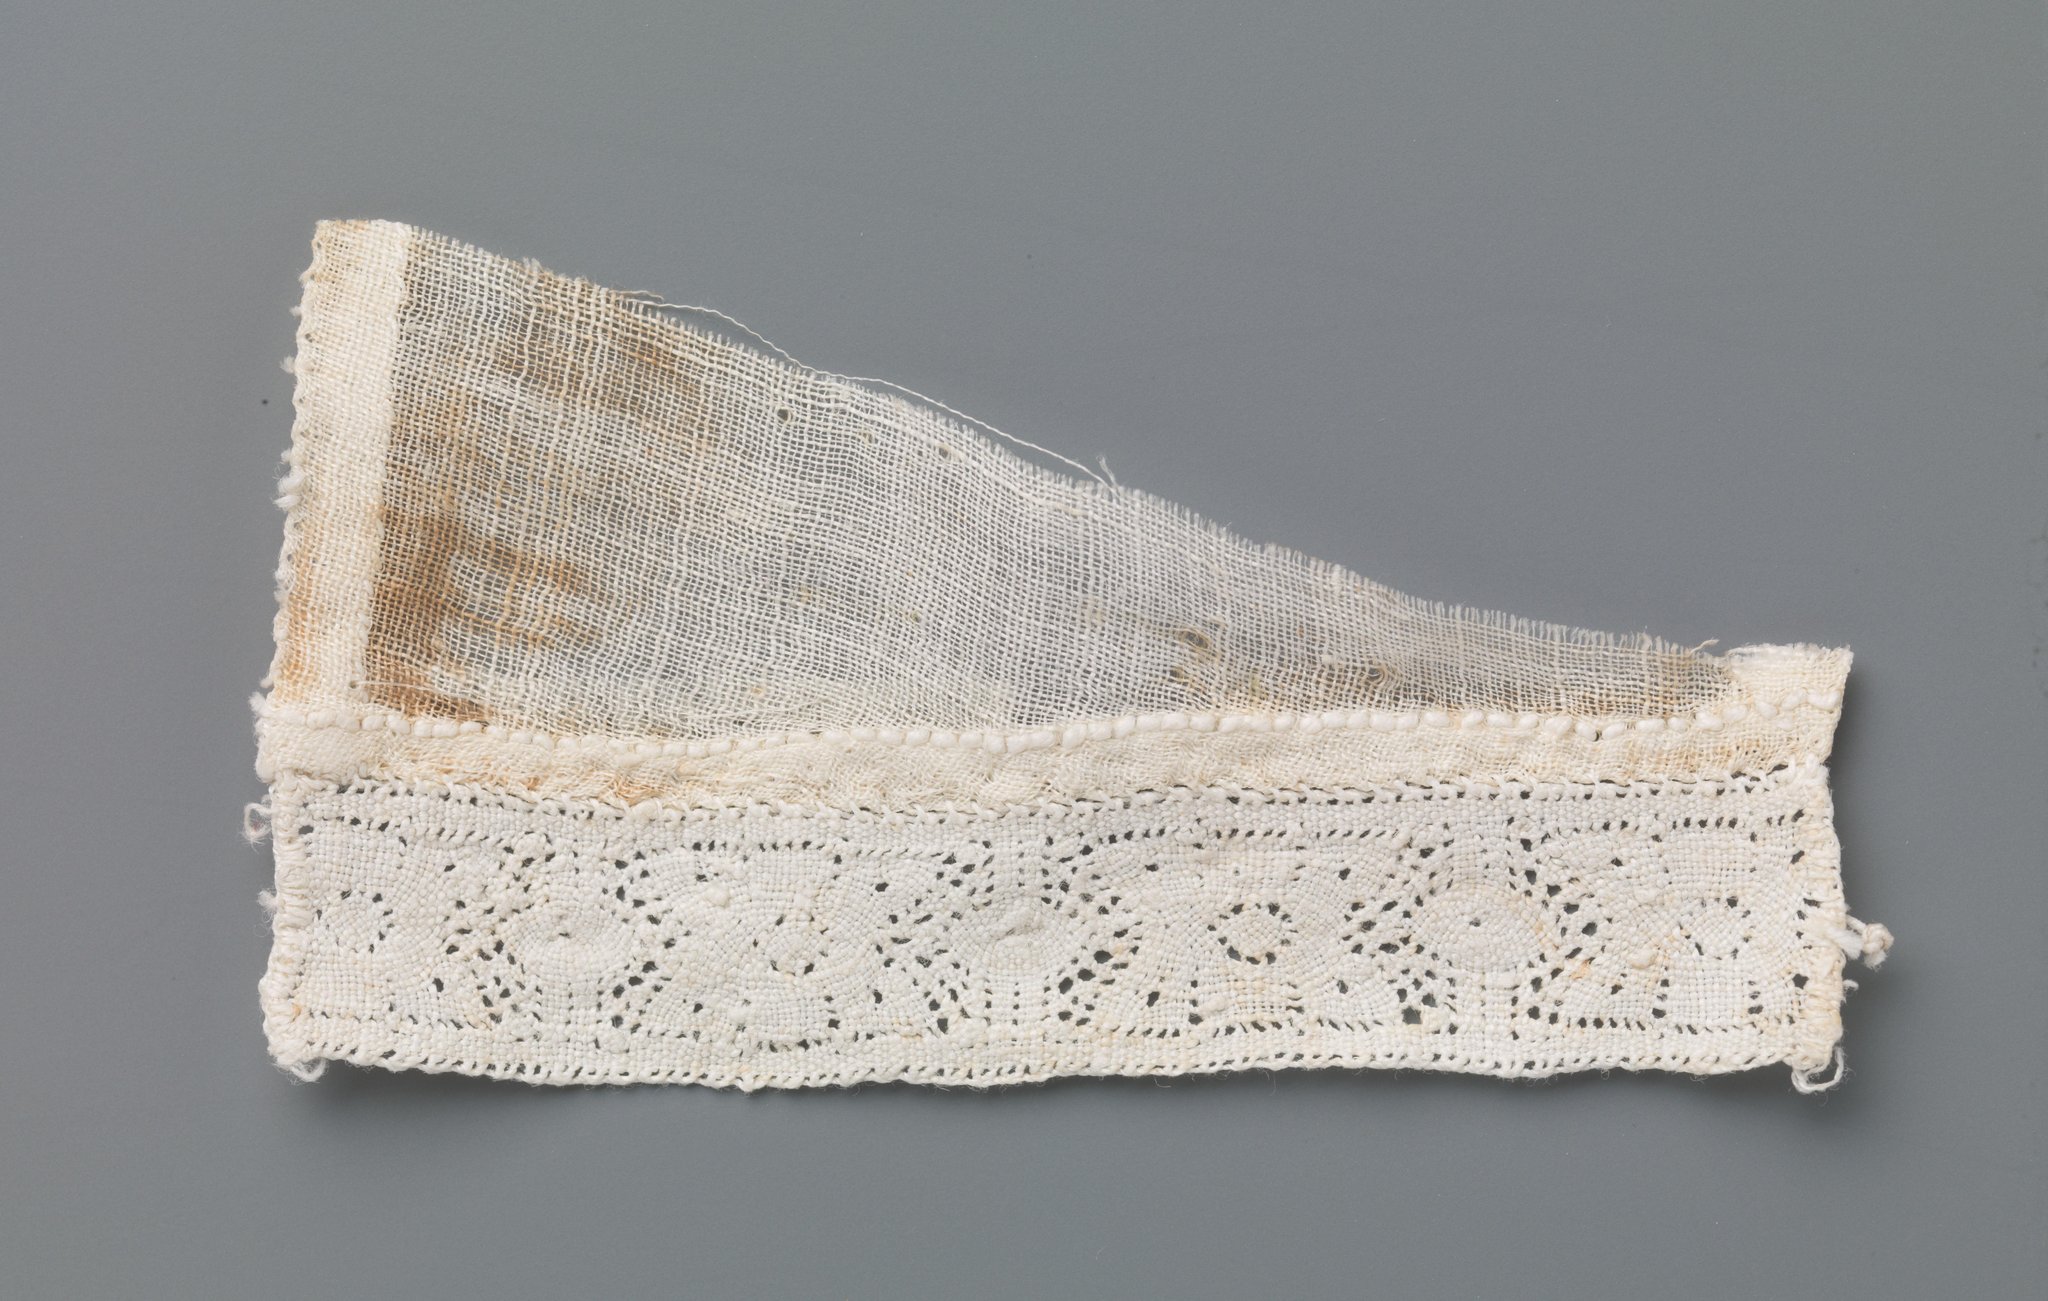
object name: strip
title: Strookje kloskant met gestileerde bloem tussen twee vertikale lijnen en ovalen aan een driehoekig fragment linnen batist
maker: Anonymous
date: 1600-1635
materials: linen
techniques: lace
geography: southern netherlands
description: Strookje naturelkleurige kloskant, oudvlaamse kant of Hollandse kloskant. Het strookje zit vast aan een driehoekig fragment linnen batist. Het kant heeft een patroon dat bestaat uit vertikale rechte lijnen, waartussen een gestileerde bloem staat. Op de middenlijn wordt de bloem links en rechts geflankeerd door een liggend spitsovaaltje, dat de vertikale lijn steeds oversnijdt. De motieven zijn gemaakt in linnenslag met uitsparingen, er is nauwelijks sprake van een grond, de motieven zijn door zeer korte vlechtjes met elkaar verbonden. Boven- en onderzijde van het strookje zijn afgewerkt met een rechte rand.